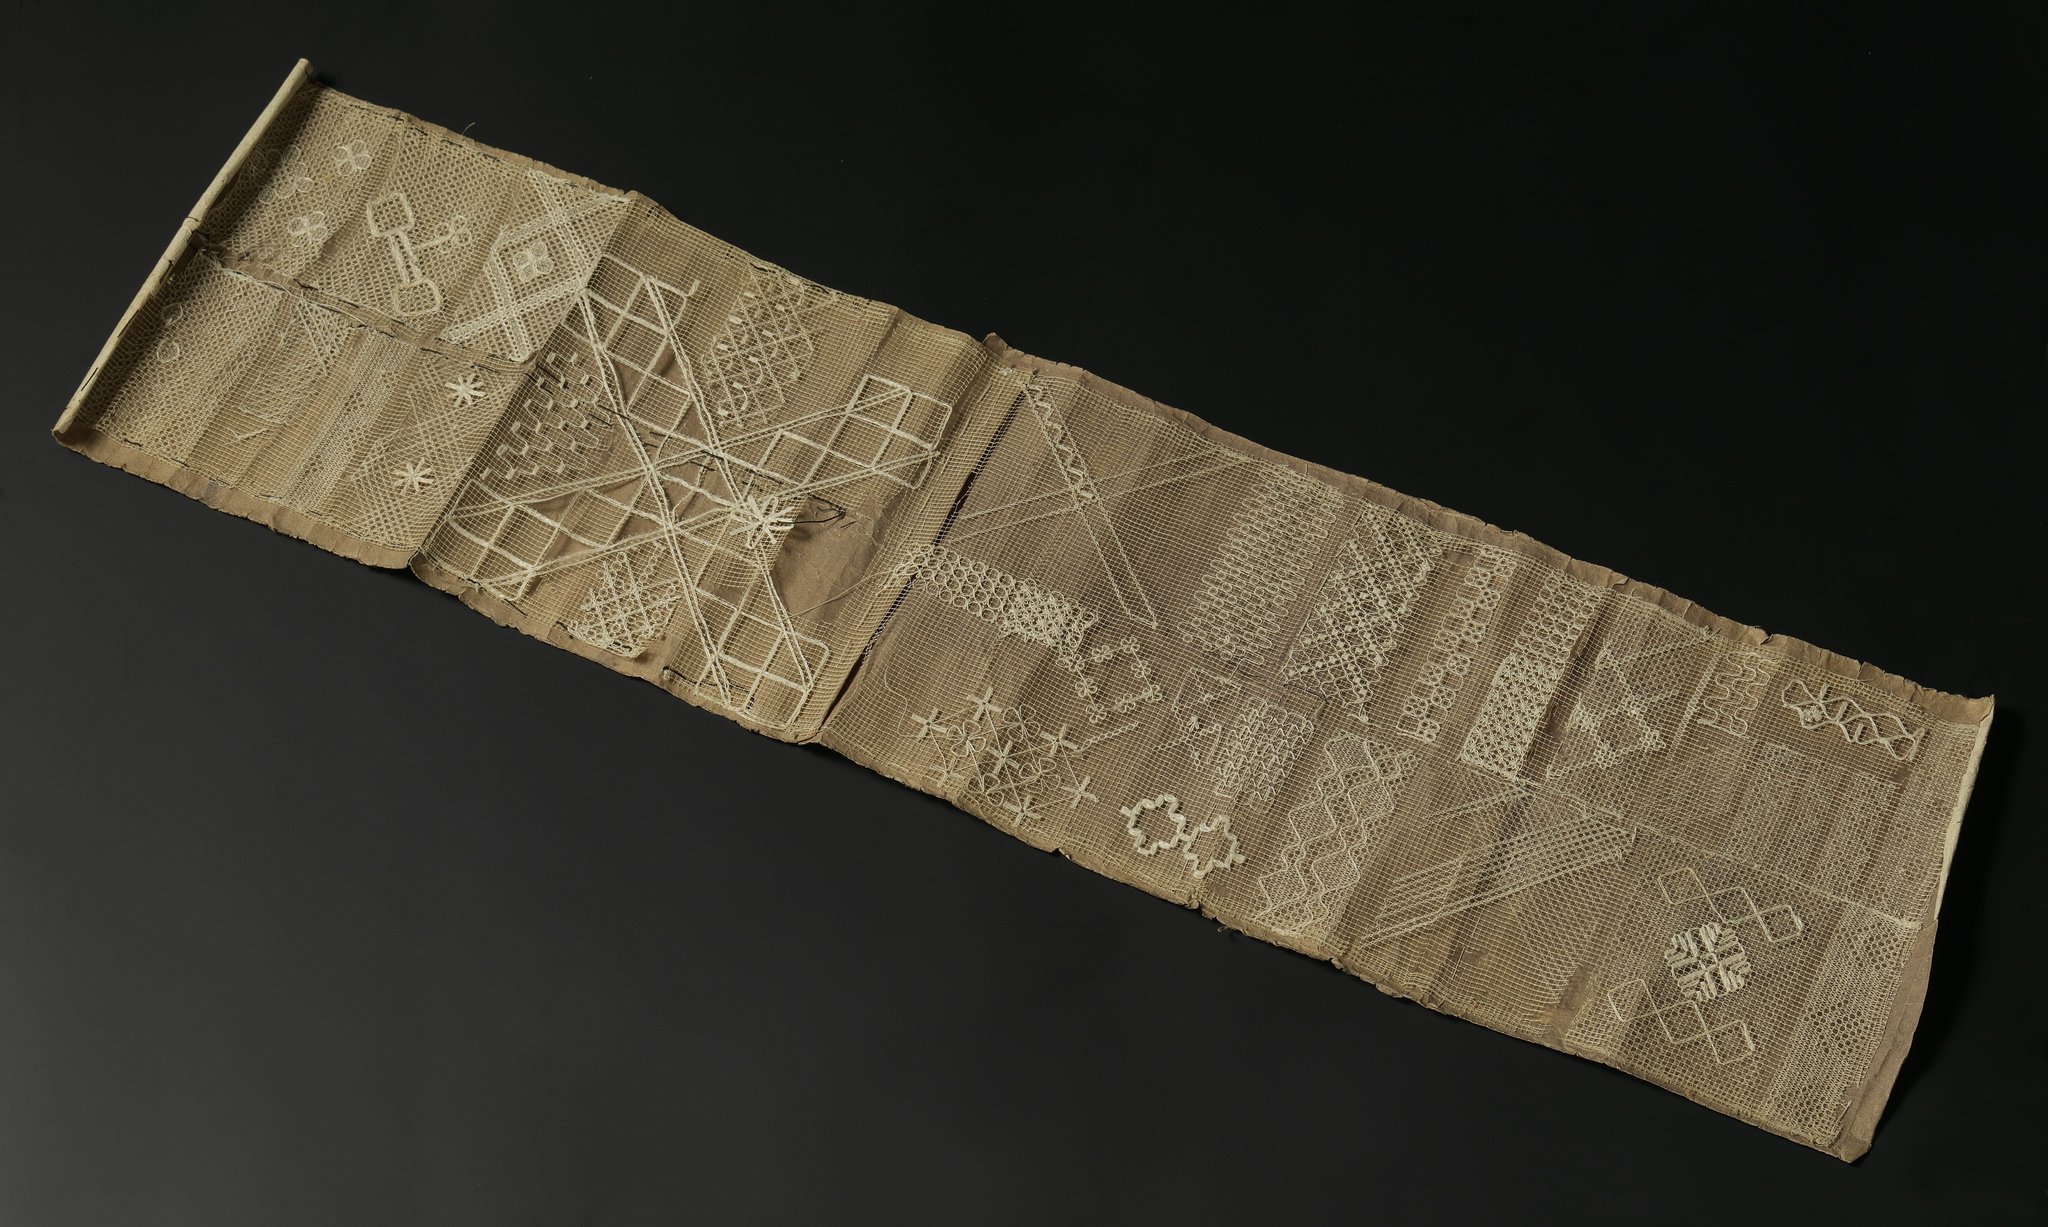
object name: merkdoek, merklap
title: Proeflap van filetkant met dertig doorstopvariaties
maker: Anonymous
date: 1900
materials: paper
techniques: embroidered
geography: netherlands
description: Proeflap van naturelkleurig kantborduurwerk, filetkant, met een dertigtal doorstopvariaties. Het betreft twee stroken die op een stuk dik papier zijn vastgemaakt.